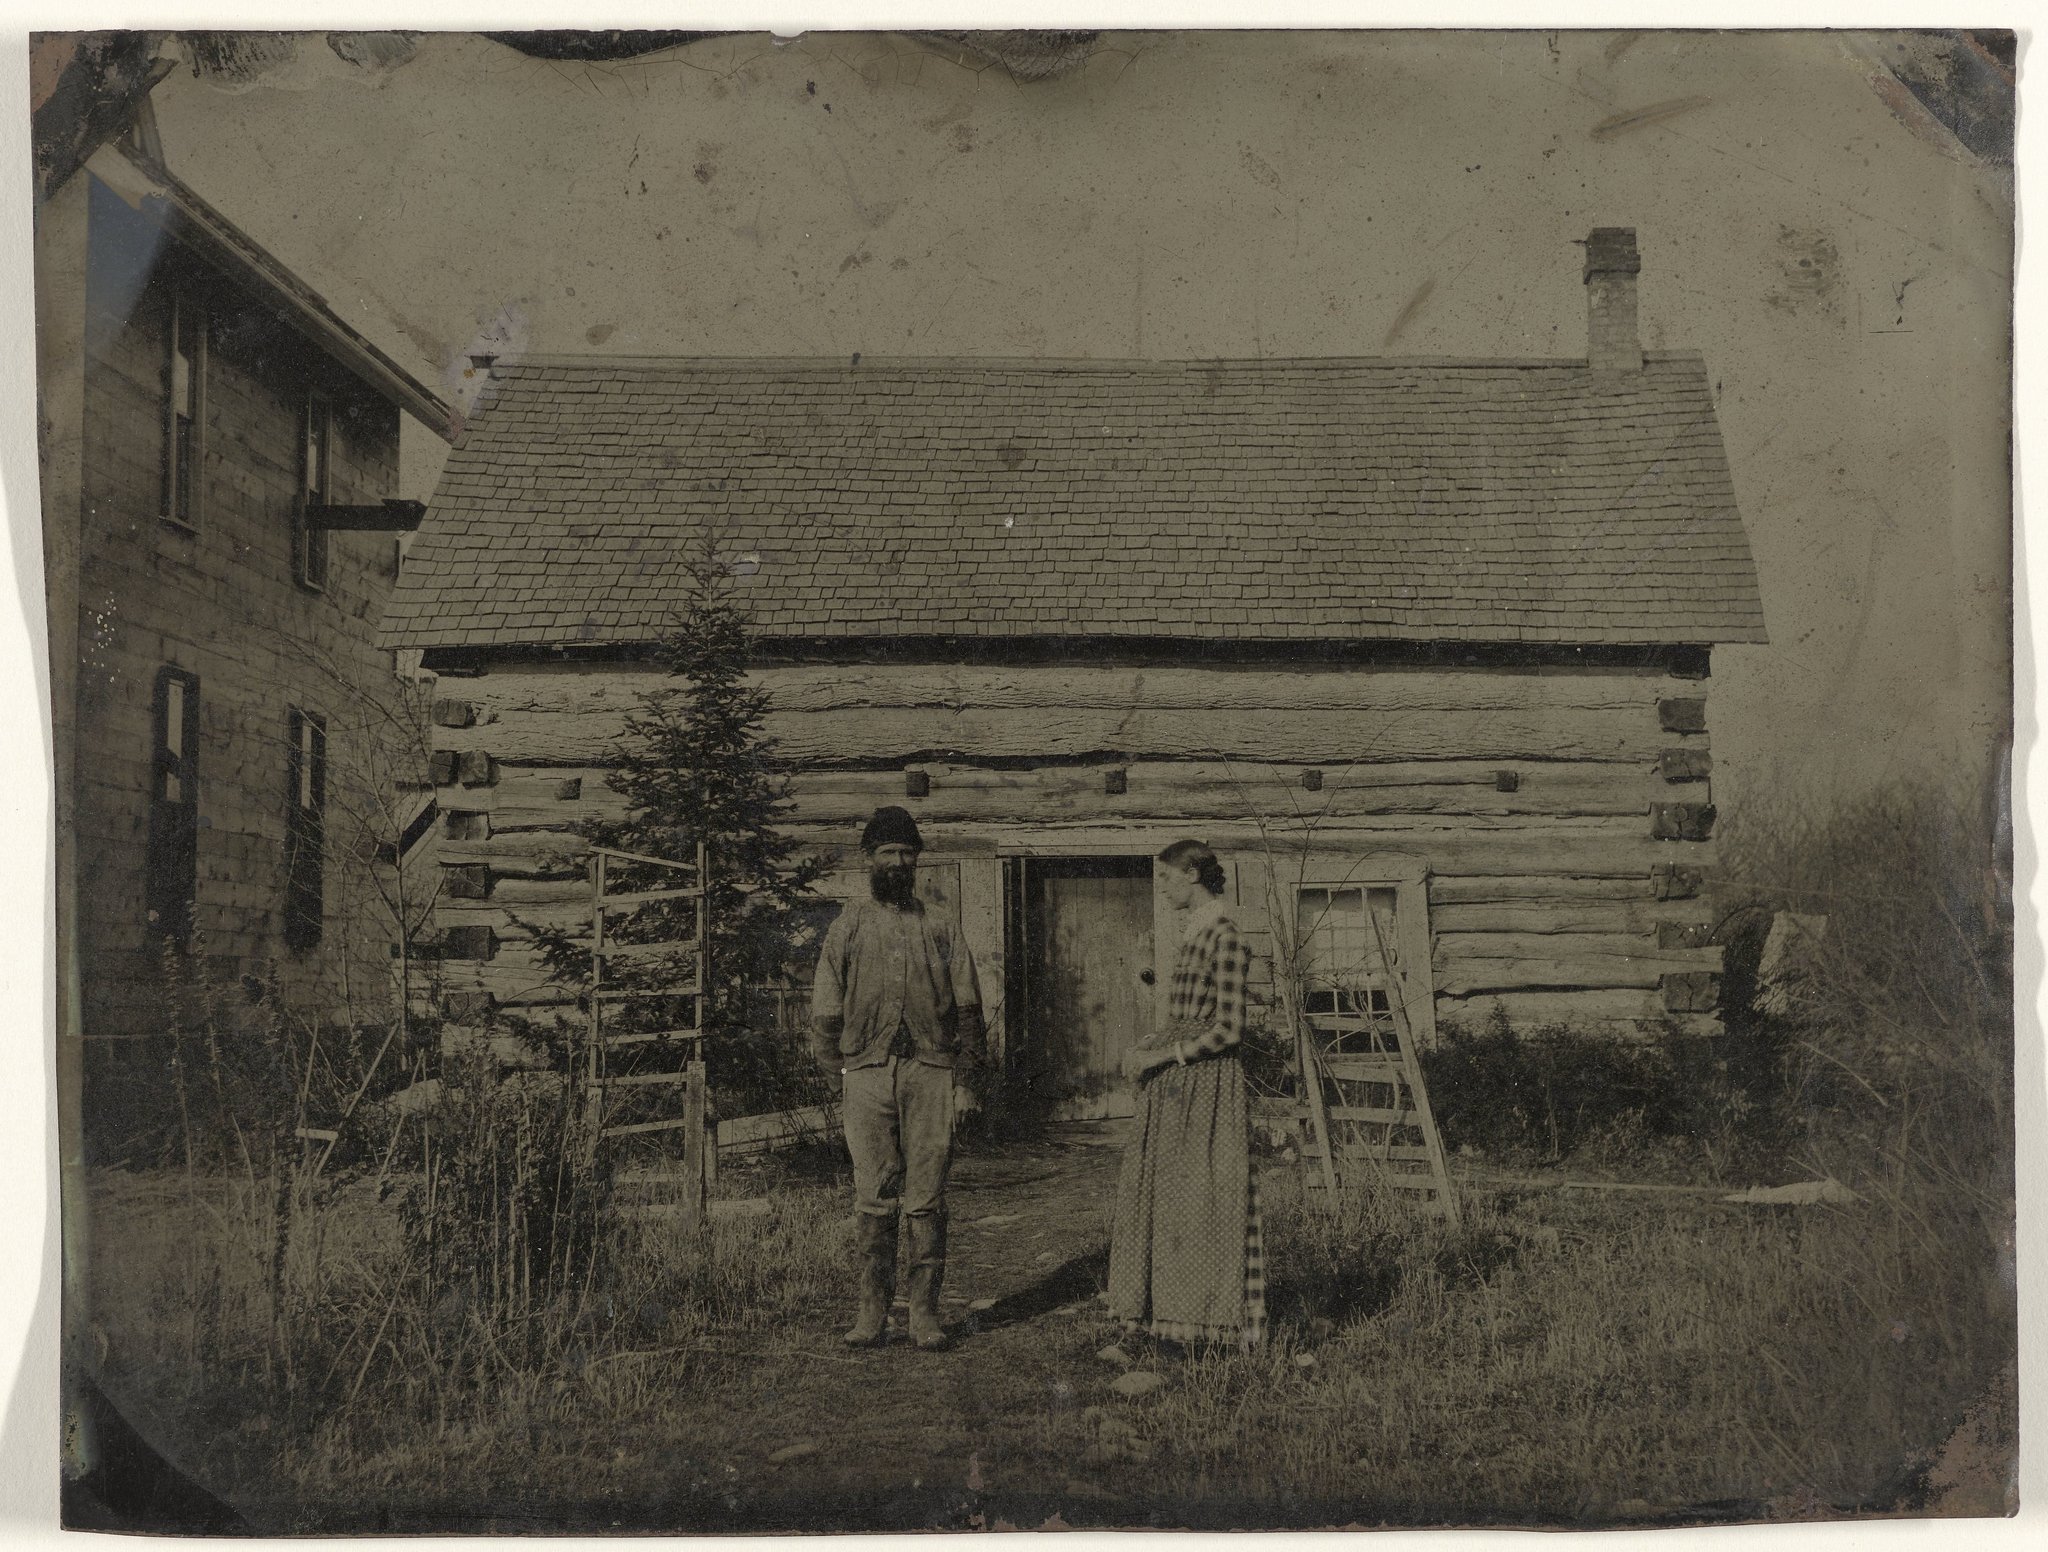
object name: photograph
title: Groepsportret van zes vrouwen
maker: Anonymous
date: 1903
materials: cardboard, photographic support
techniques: albumen print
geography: netherlands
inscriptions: date: ‘Pinksteren Mei 1903’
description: Vijf in lichte kleuren geklede vrouwen en een in het zwart geklede vrouw, zittend en staand rond een tafel met theeservies, in het bos.